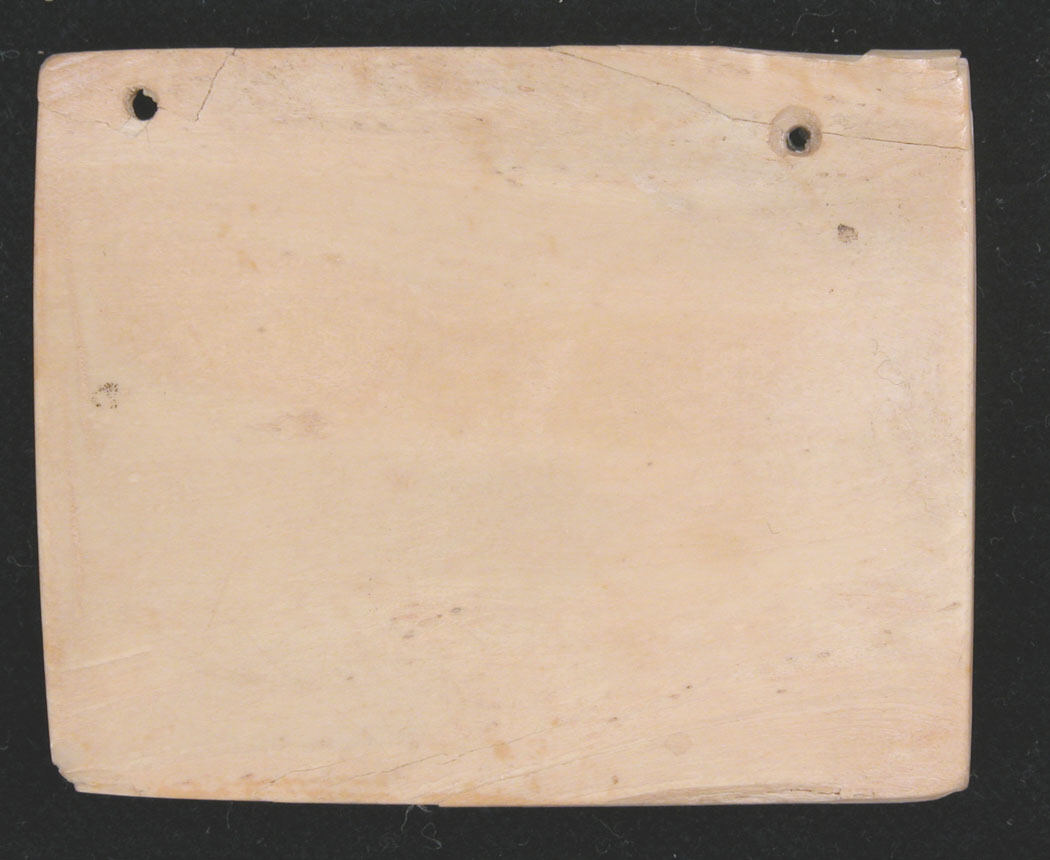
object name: plaque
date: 401-800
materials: bone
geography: palestine